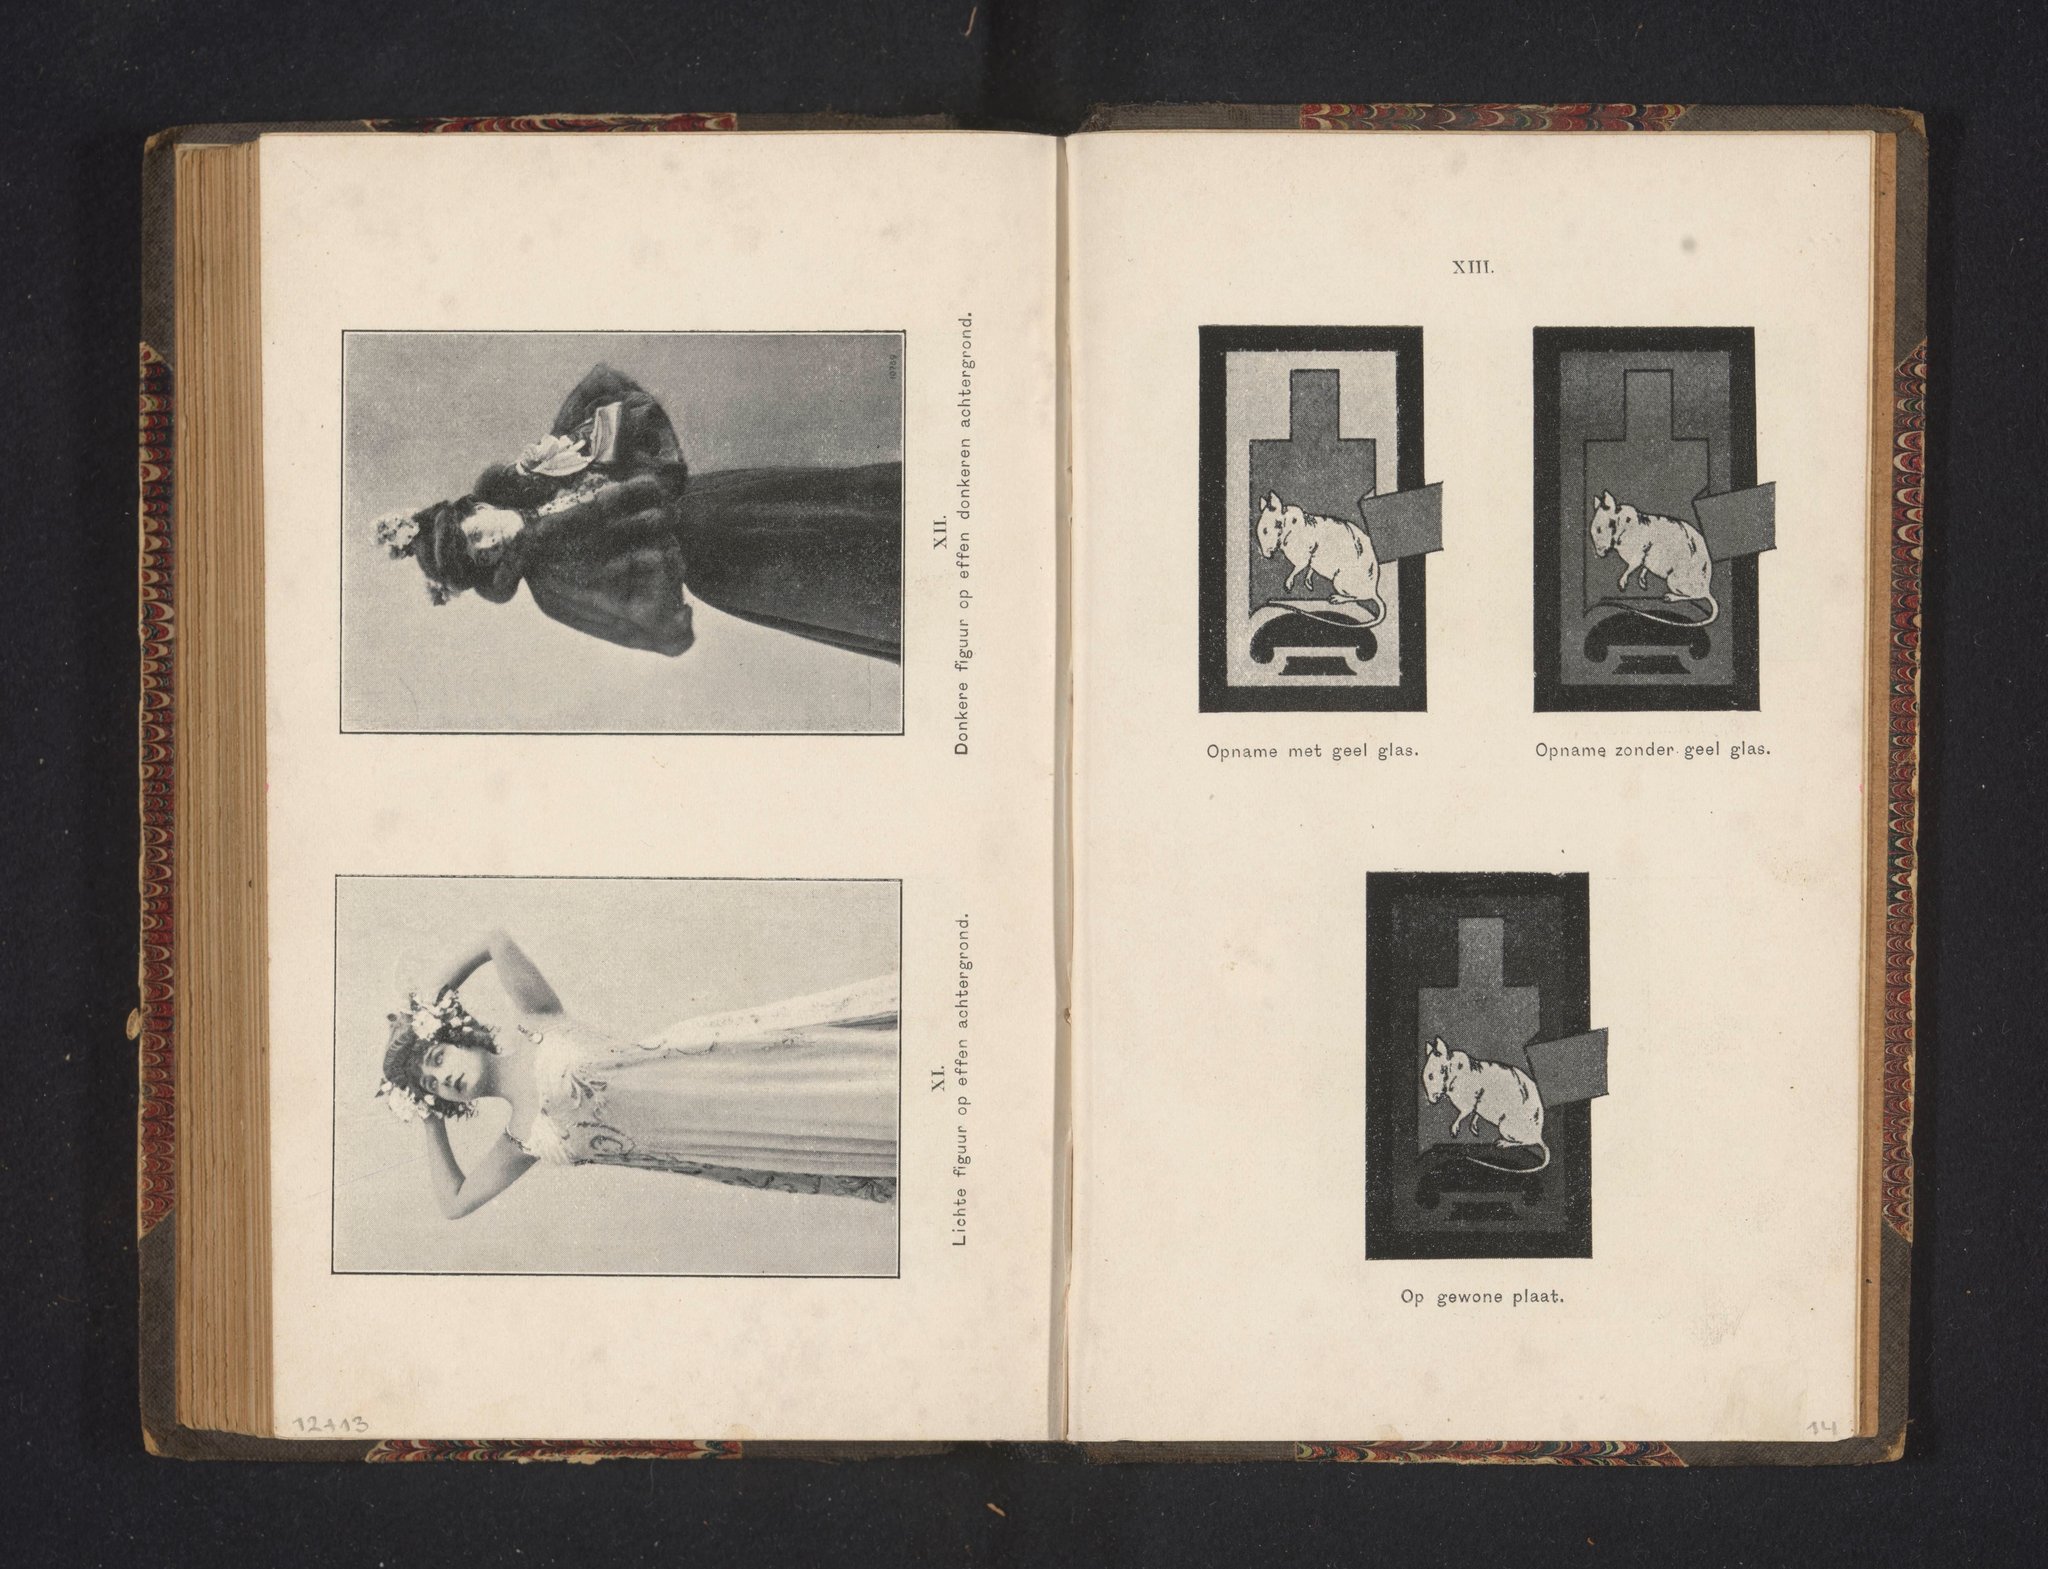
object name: photomechanical print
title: XI./ Lichte figuur op effen achtergrond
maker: Anonymous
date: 1897-1902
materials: paper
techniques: autotype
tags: historical persons not known by name - bb - woman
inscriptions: number: ‘11451’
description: Prent elf van veertien prenten na pagina 241.